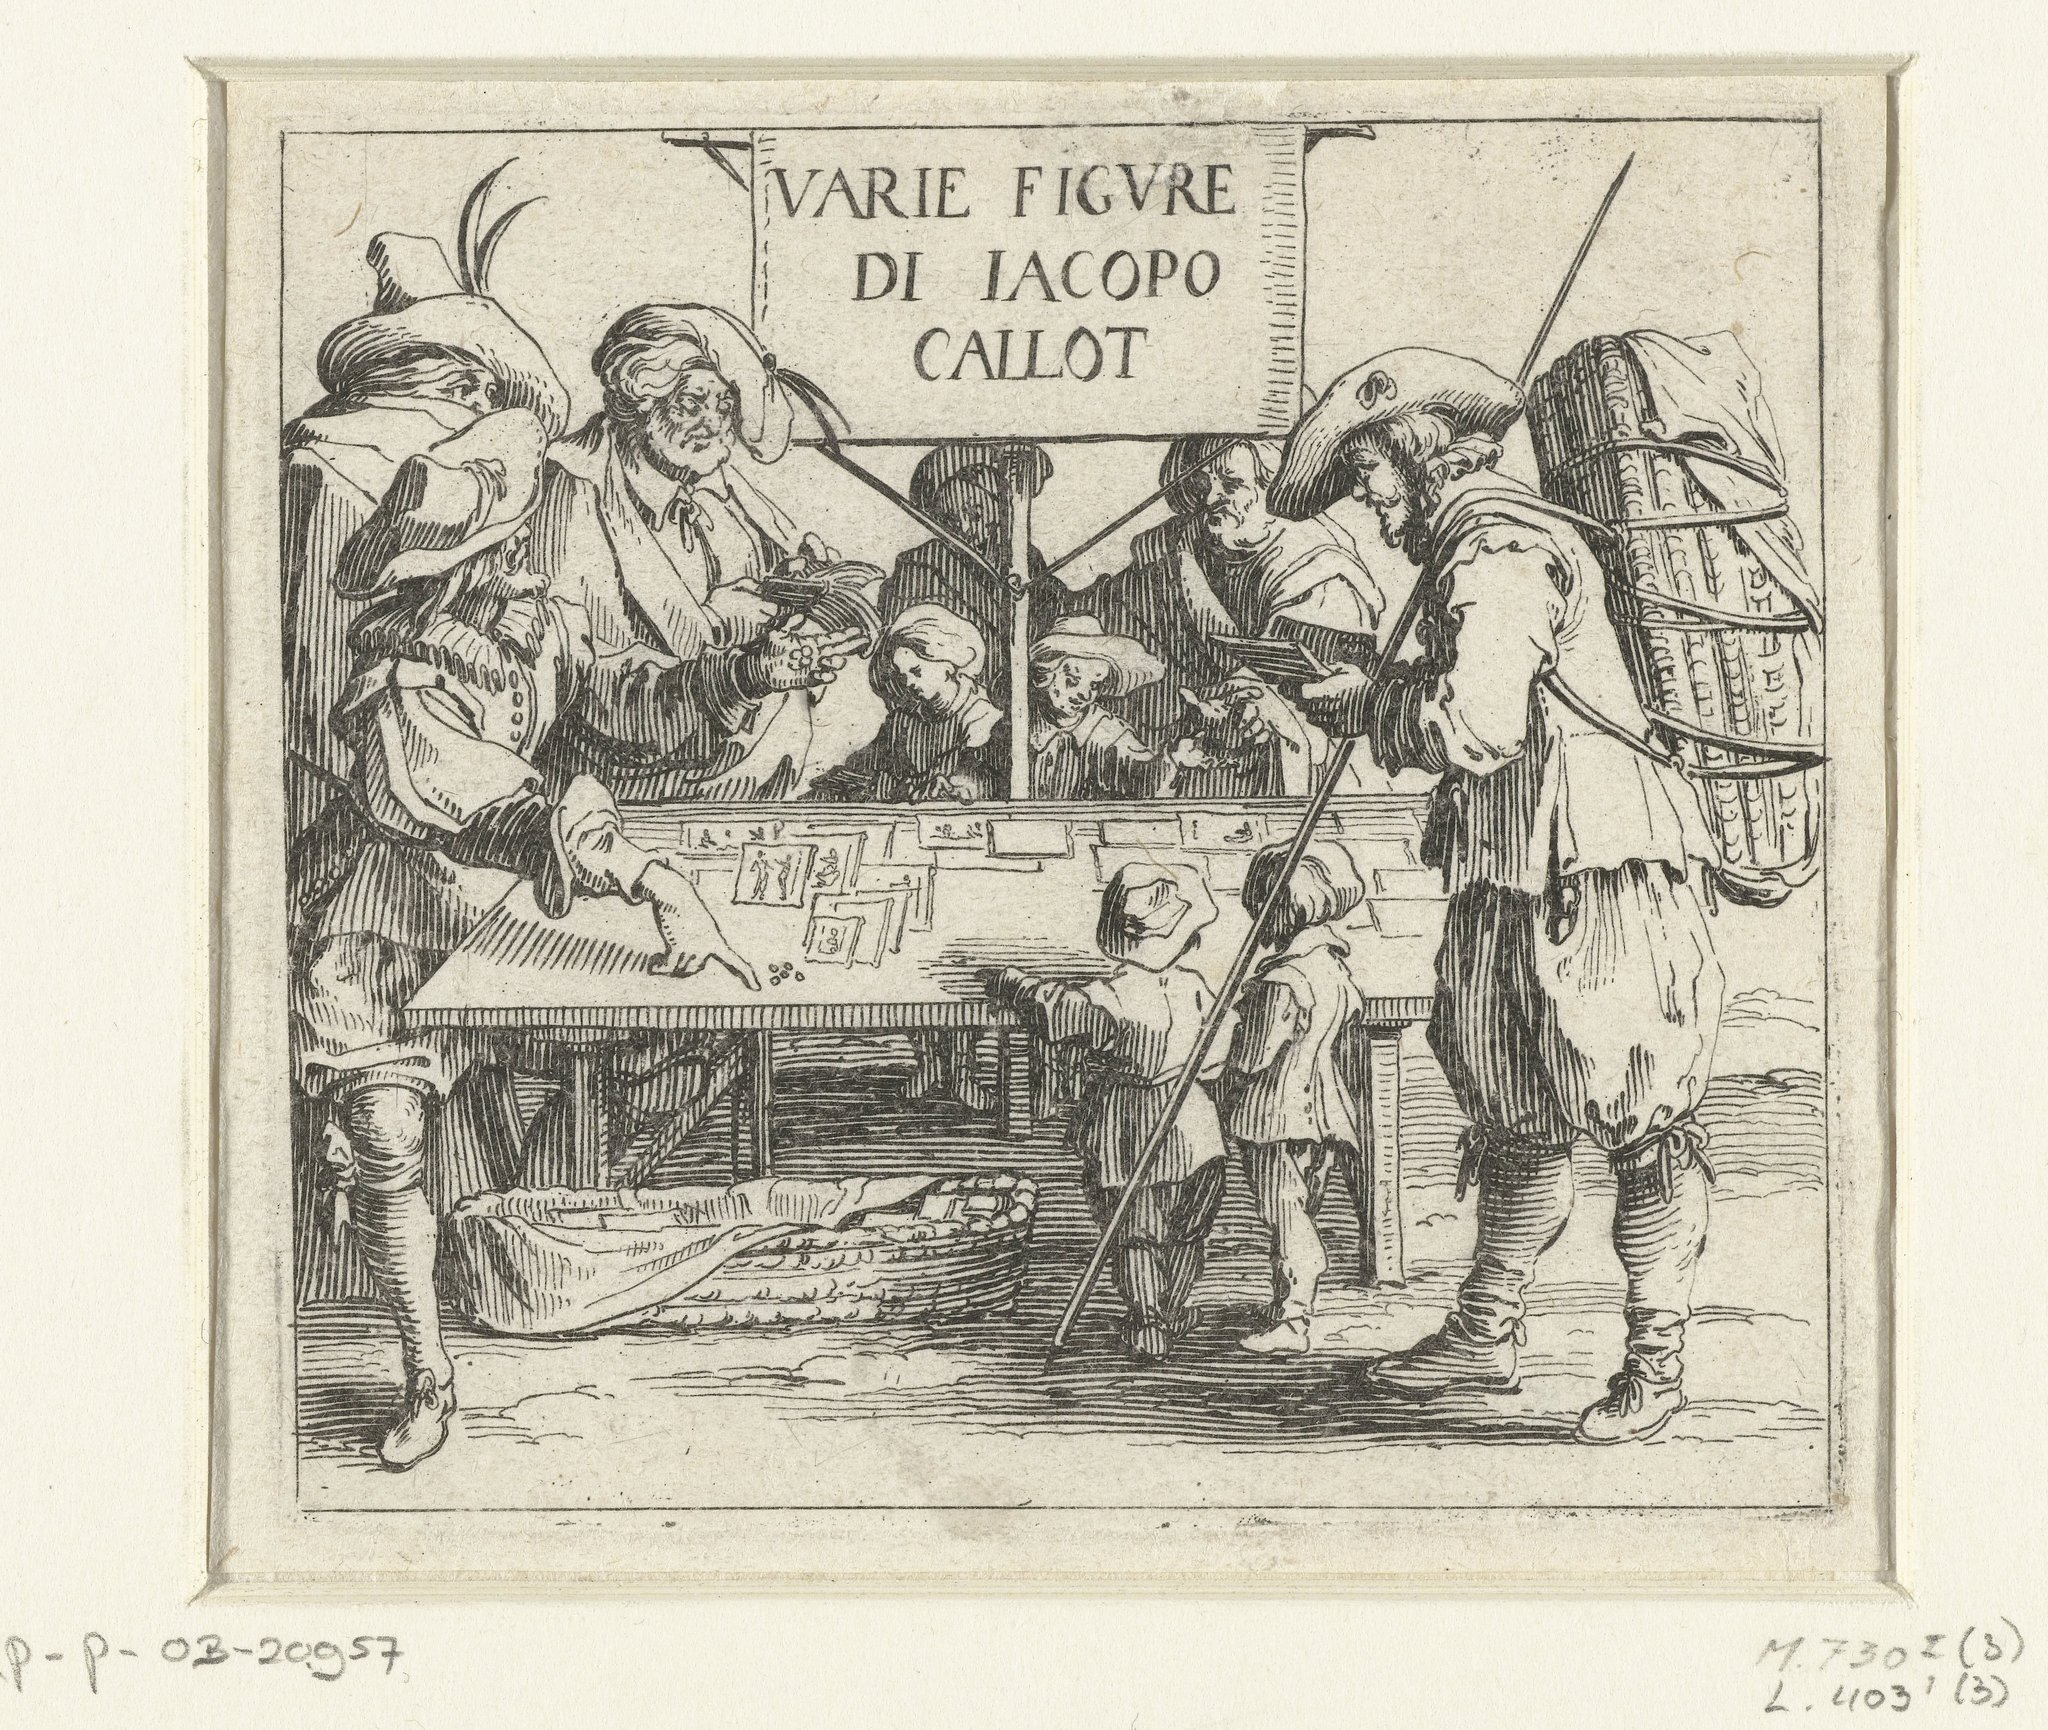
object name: print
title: Diverse figuren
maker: jacques callot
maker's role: draughtsman, print maker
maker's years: 1592-1635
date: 1621-1624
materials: paper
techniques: etching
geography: nancy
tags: print, e.g.: engraving, etching, lithograph, buying and selling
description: Een prenthandelaar aan een tafel, waarop hij zijn waar uitgestald heeft. Een groep klanten heeft zich om zijn tafel geschaard, onder hen enkele kinderen en een man met een groot pak op zijn rug. Bij de tafel staat een bord met daarop titel en maker van de prentreeks. Dit is namelijk de titelprent voor een serie van 16 prenten (15 volgens Lieure) met mannen en vrouwen in diverse houdingen. Mogelijk zijn deze prenten bedoeld geweest als tekenvoorbeelden.